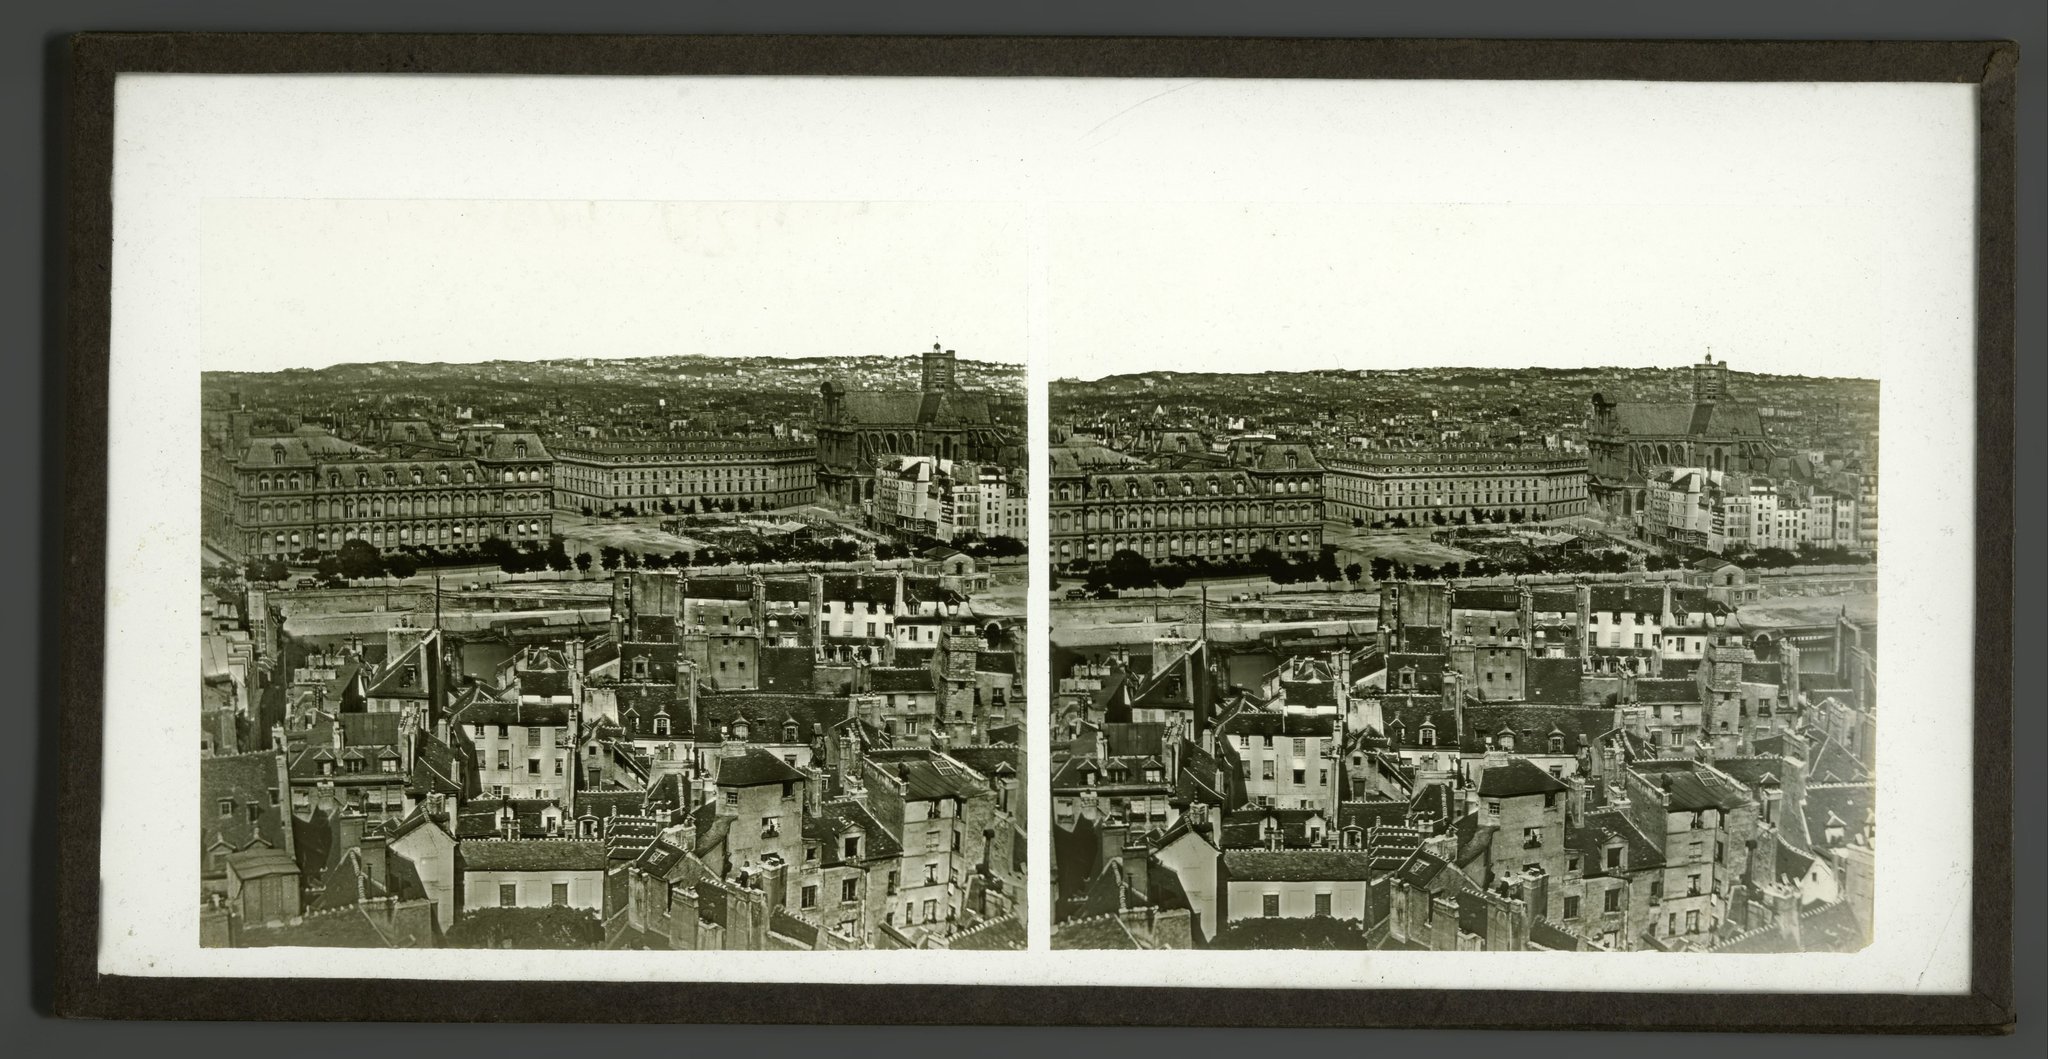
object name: stereoscopic photograph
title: Gezicht op Parijs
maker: Anonymous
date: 1856-1890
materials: glass, paper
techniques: slide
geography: paris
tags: city-view in general; 'veduta', paris